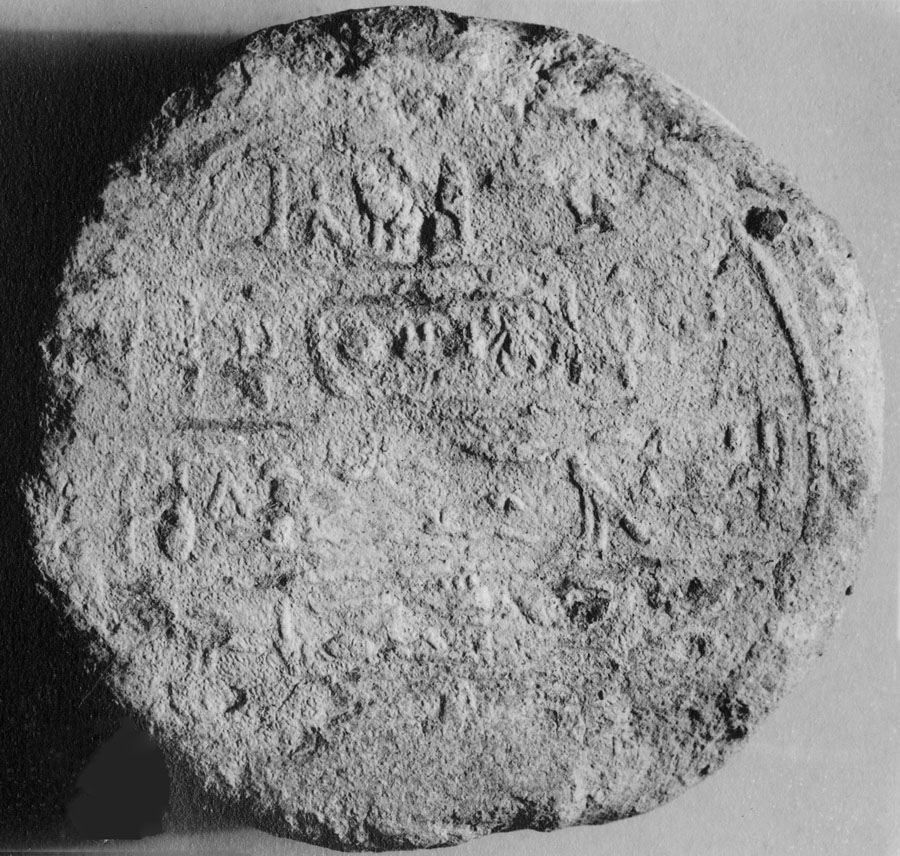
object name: cone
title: Funerary Cone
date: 1550-1295 BCE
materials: pottery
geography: egypt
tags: hieroglyphs